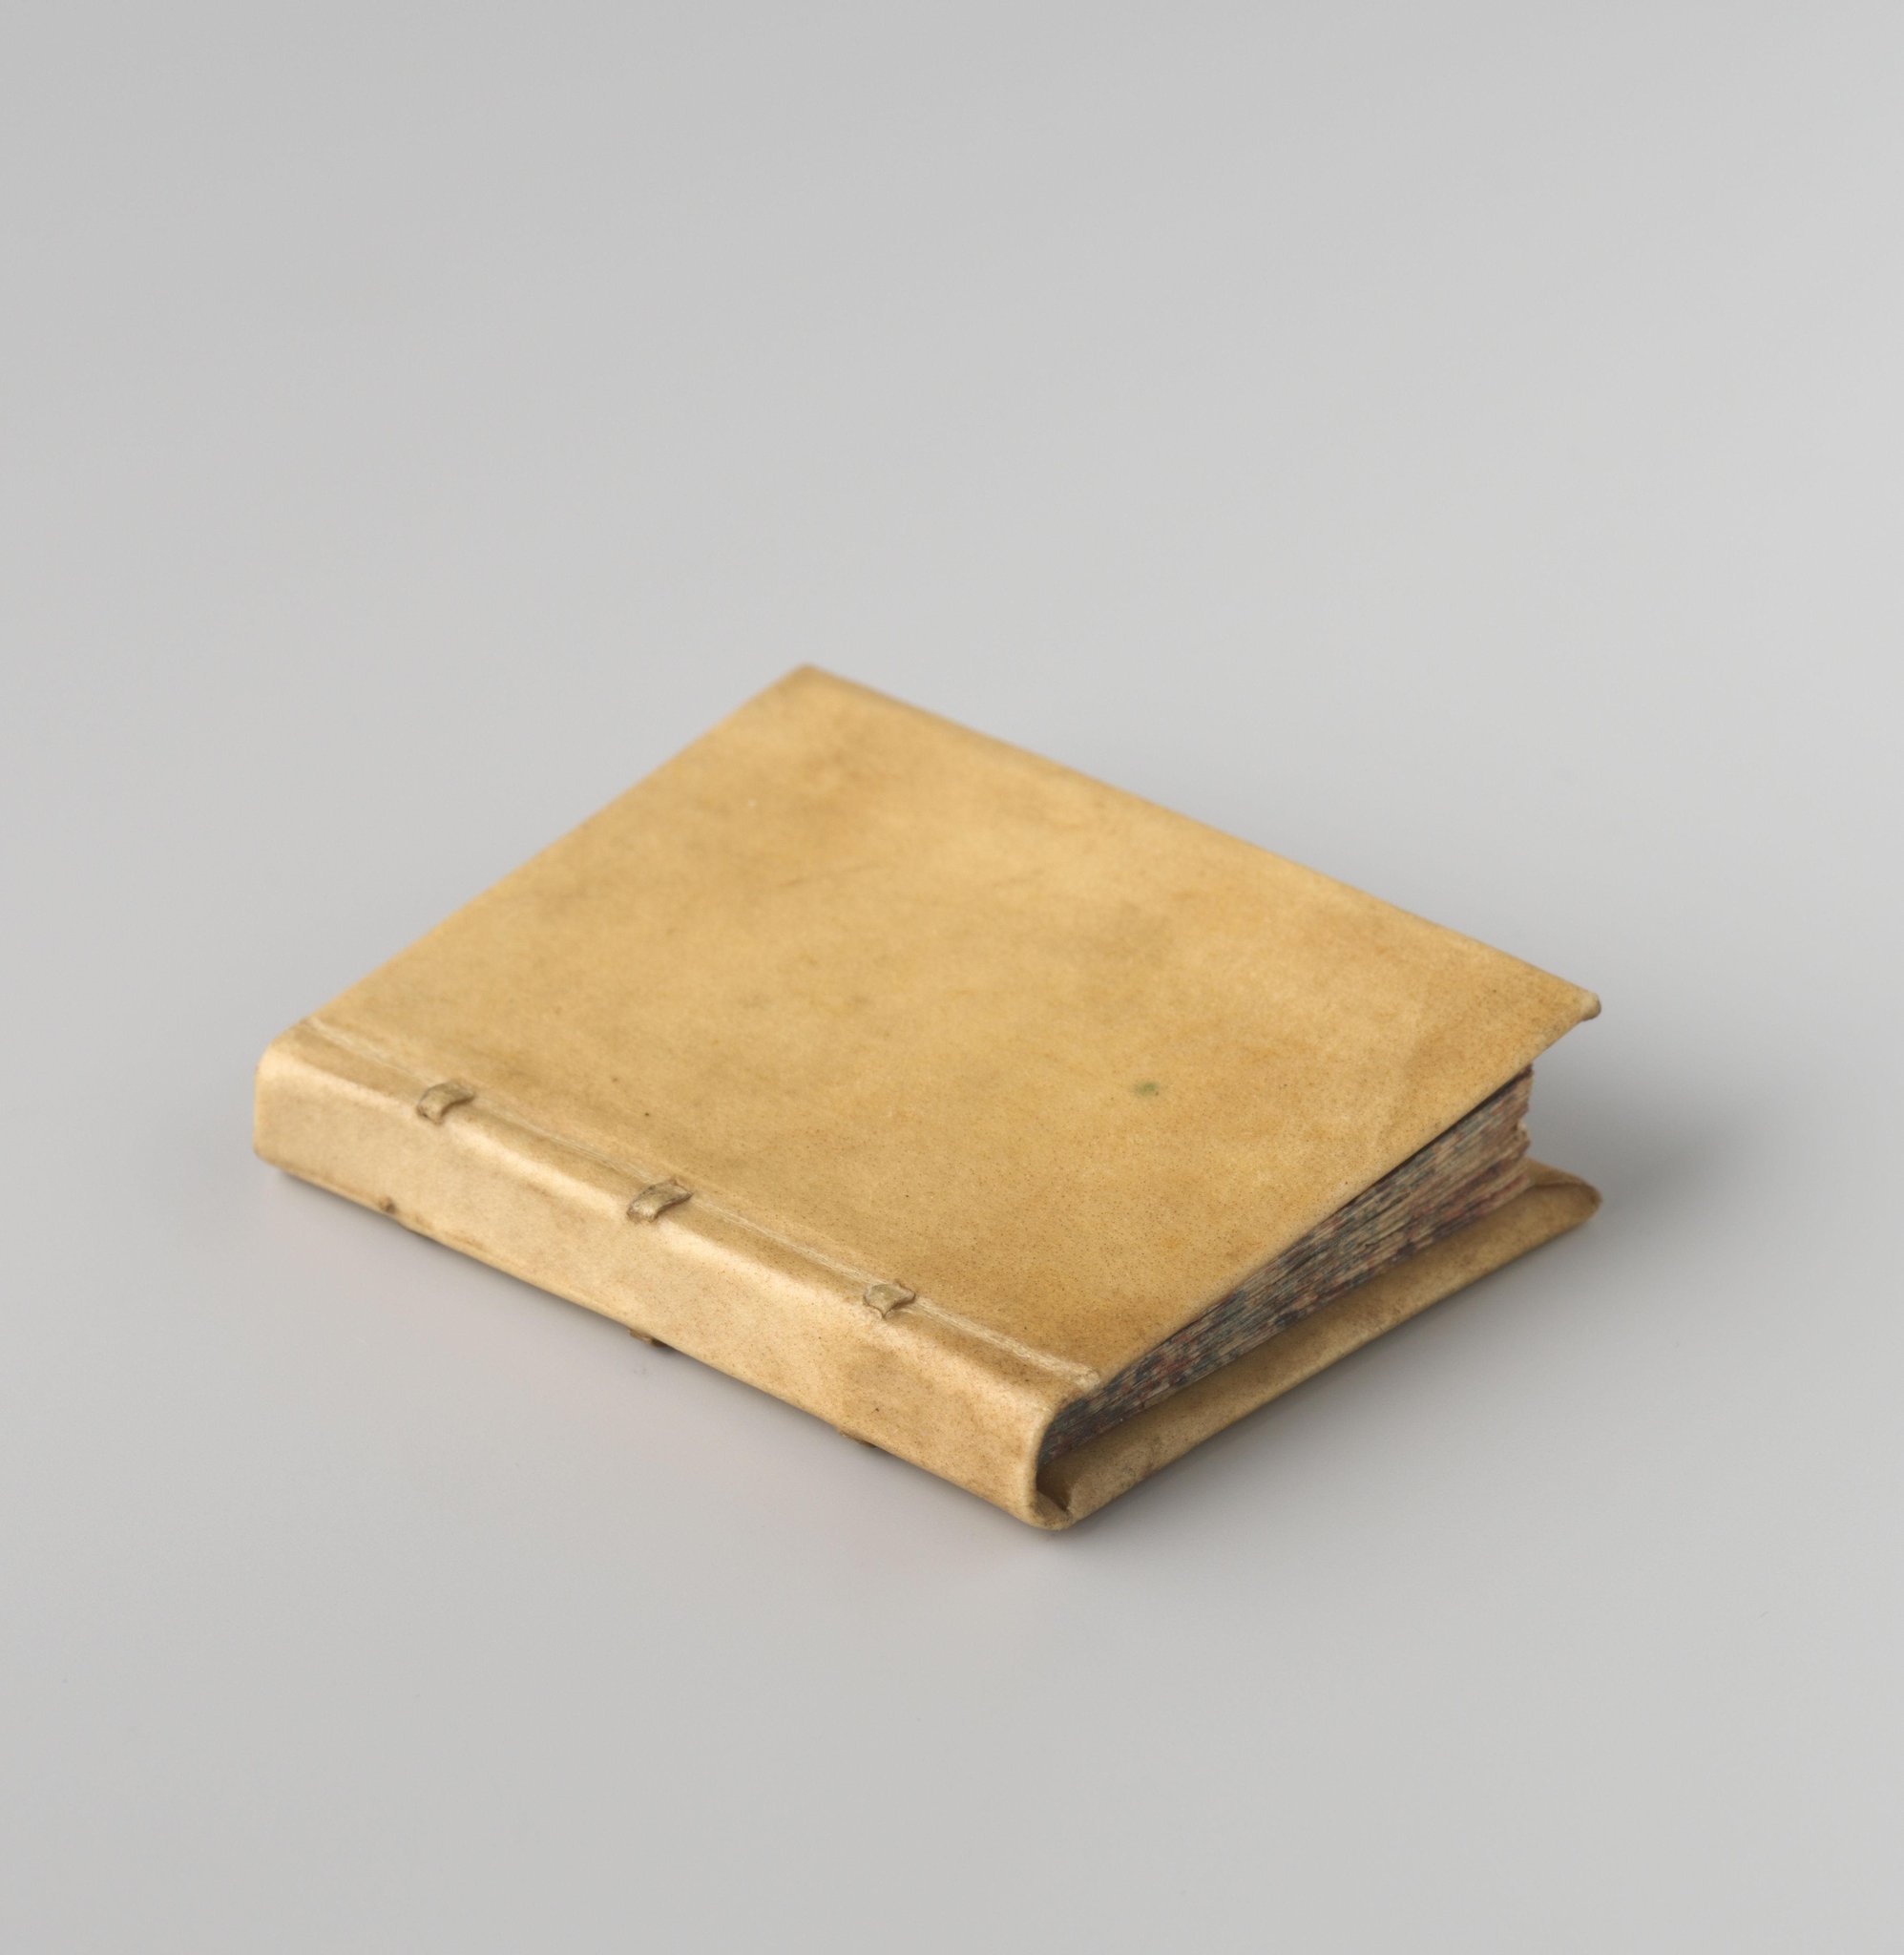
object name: book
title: Boek met prenten in kleurendruk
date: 1690-1710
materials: paper, parchment